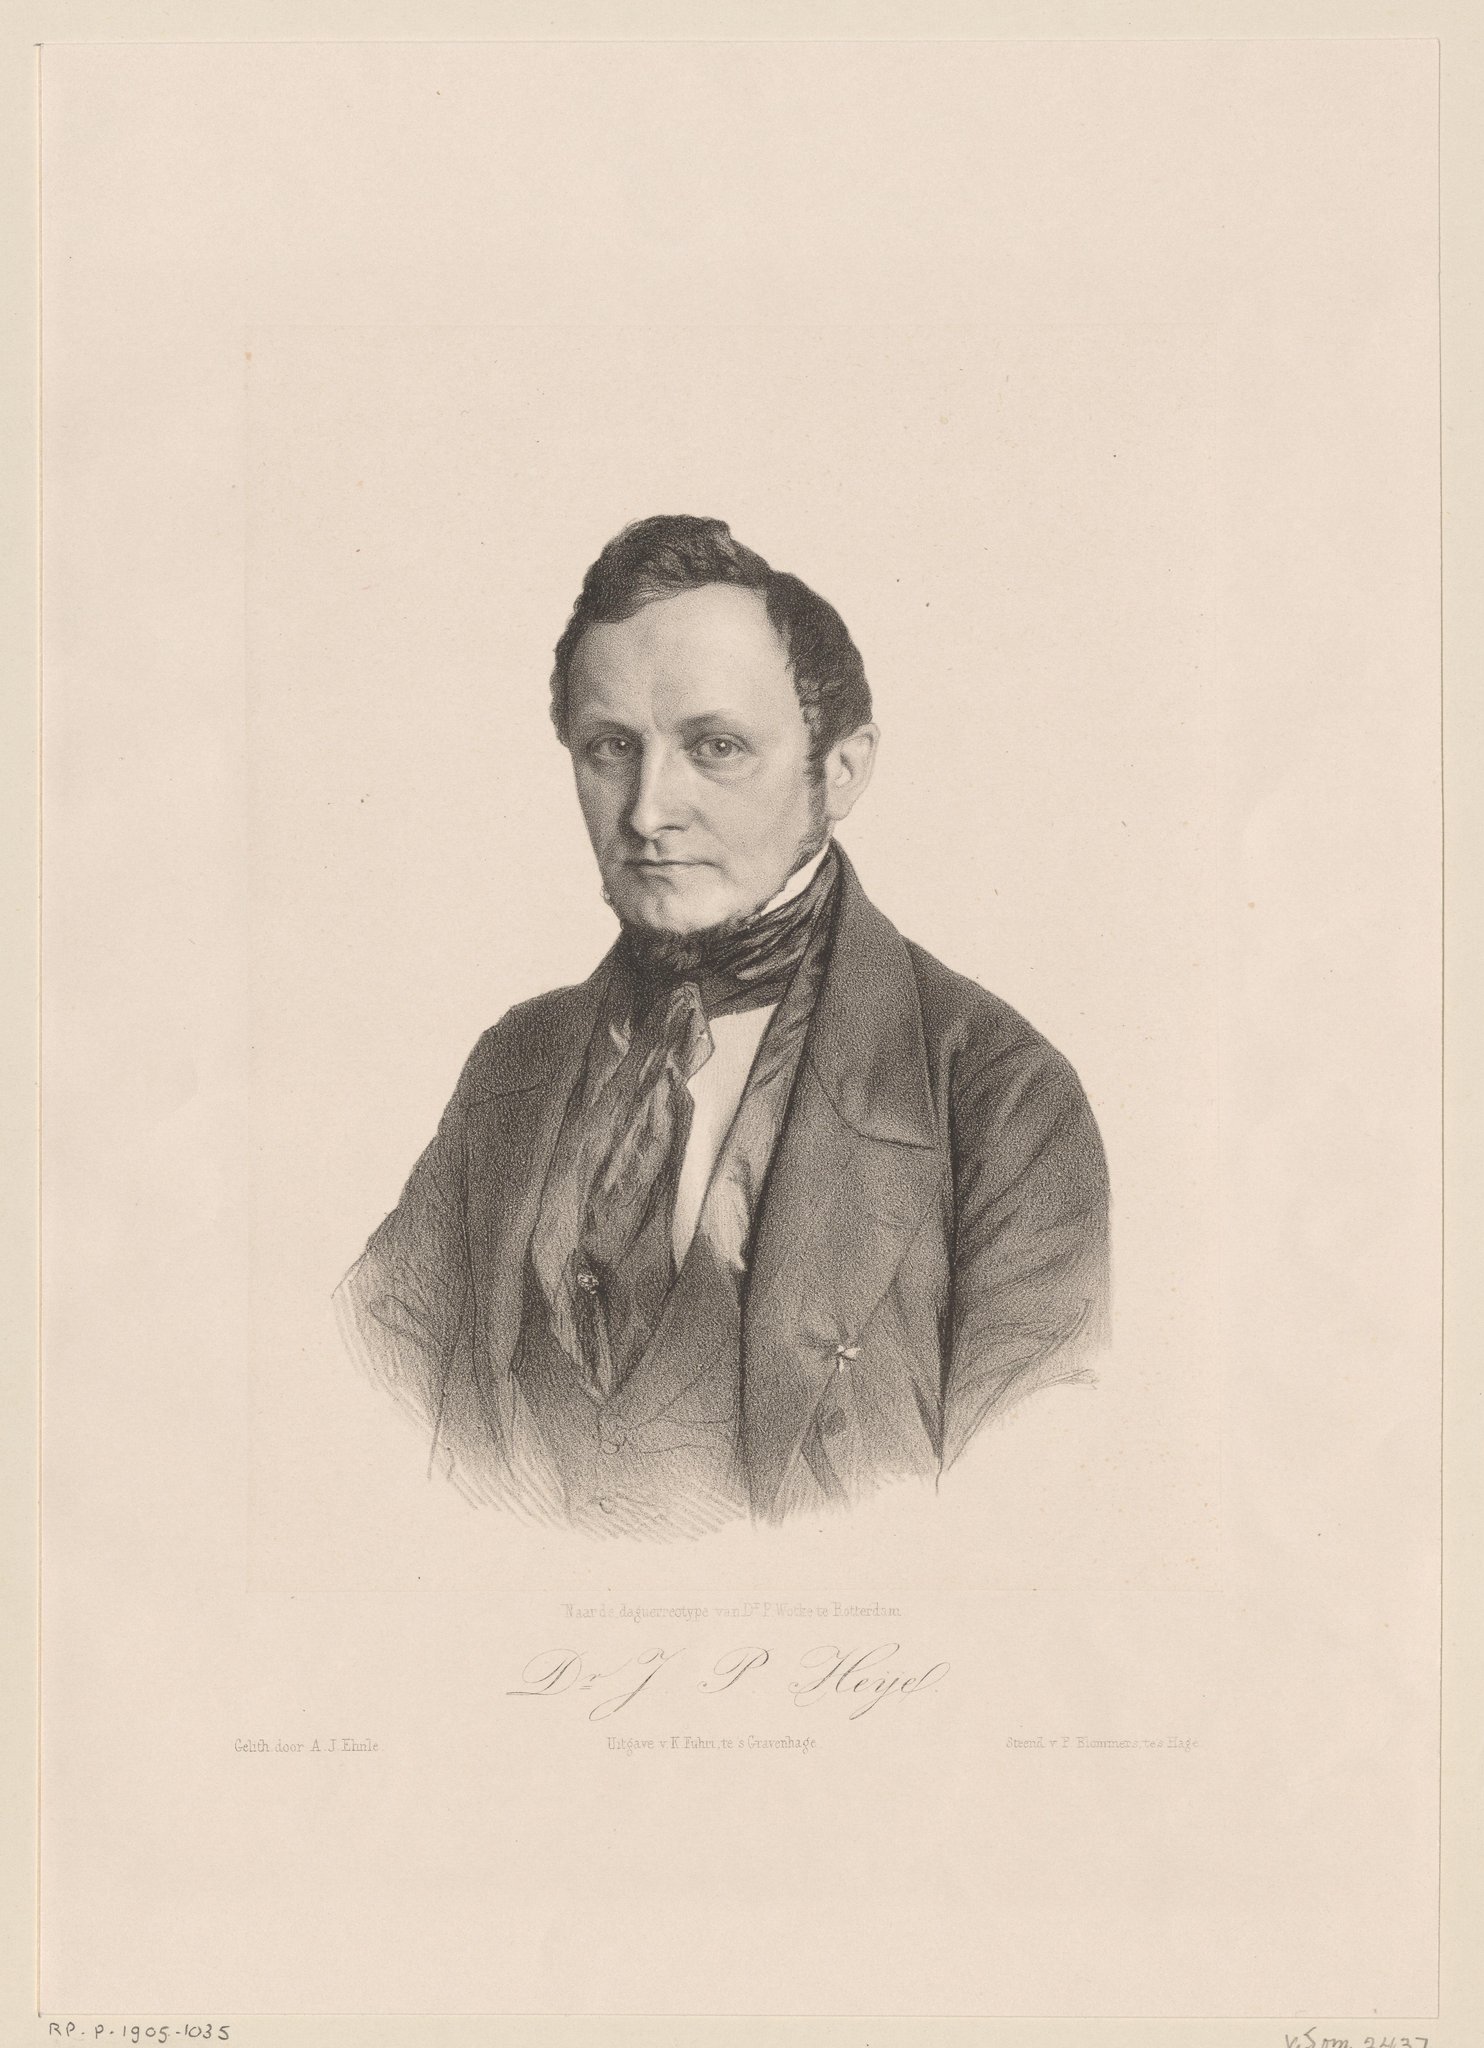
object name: print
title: Portret van Jan Pieter Heije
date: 1842-1853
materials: paper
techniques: lithograph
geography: the hague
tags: amsterdam, jan pieter heije, historical persons, physician, doctor, writer, poet, author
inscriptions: collector's mark: Lugt 2228